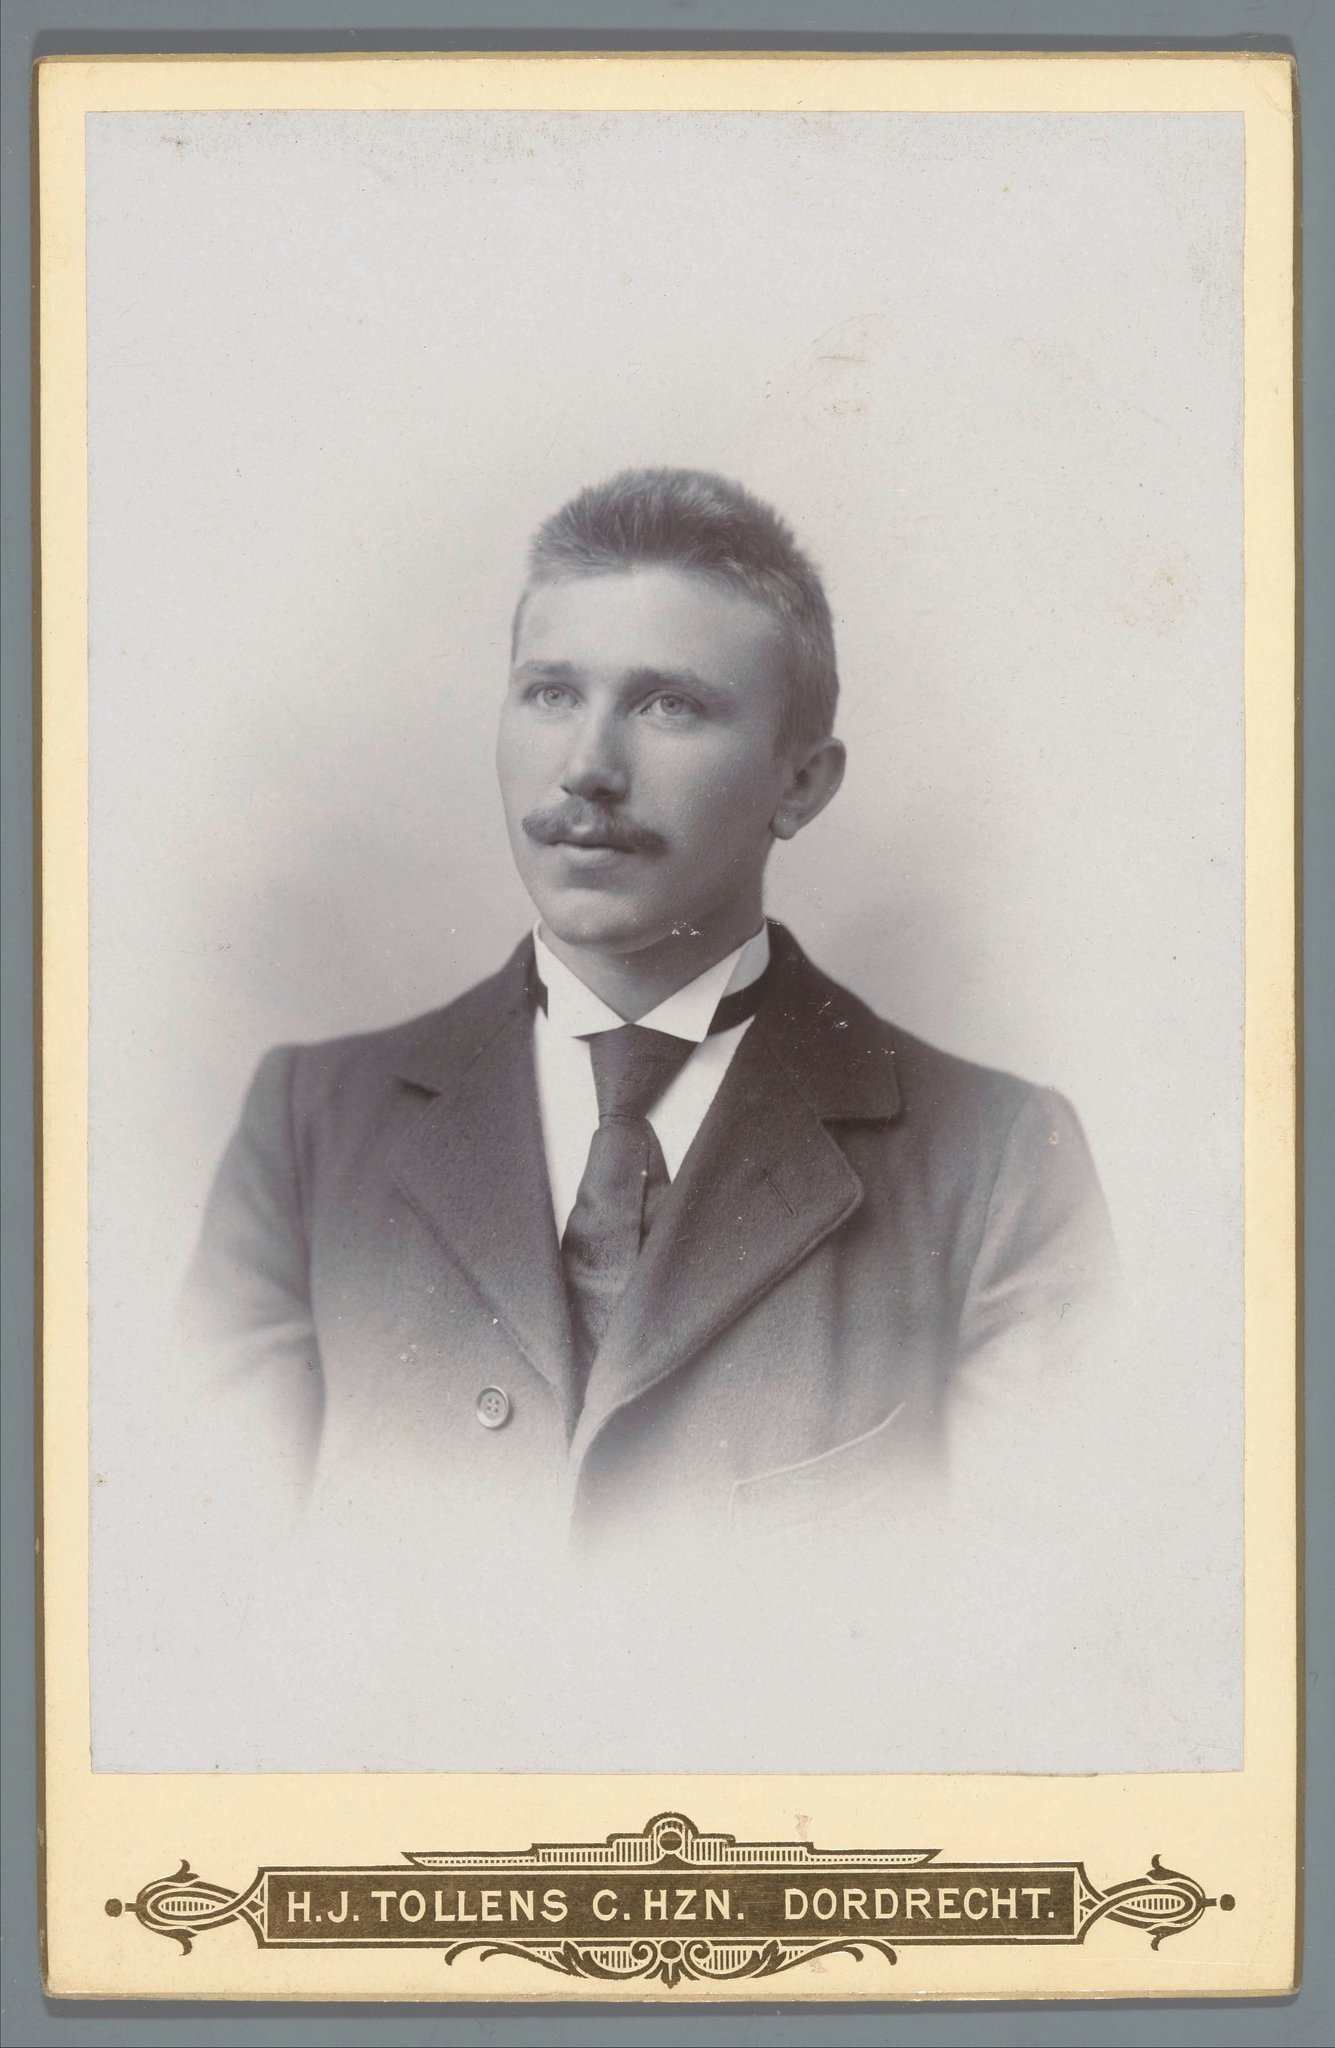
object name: cabinet photograph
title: Portret van een onbekende man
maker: henricus jacobus tollens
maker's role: painter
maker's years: 1864-1936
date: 1812-1897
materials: cardboard, photographic support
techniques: collodion silver print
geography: dordrecht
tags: adult man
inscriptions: inscription: ‘H.J. Tollens C.H.zn. (...) Negatieven worden bewaard’